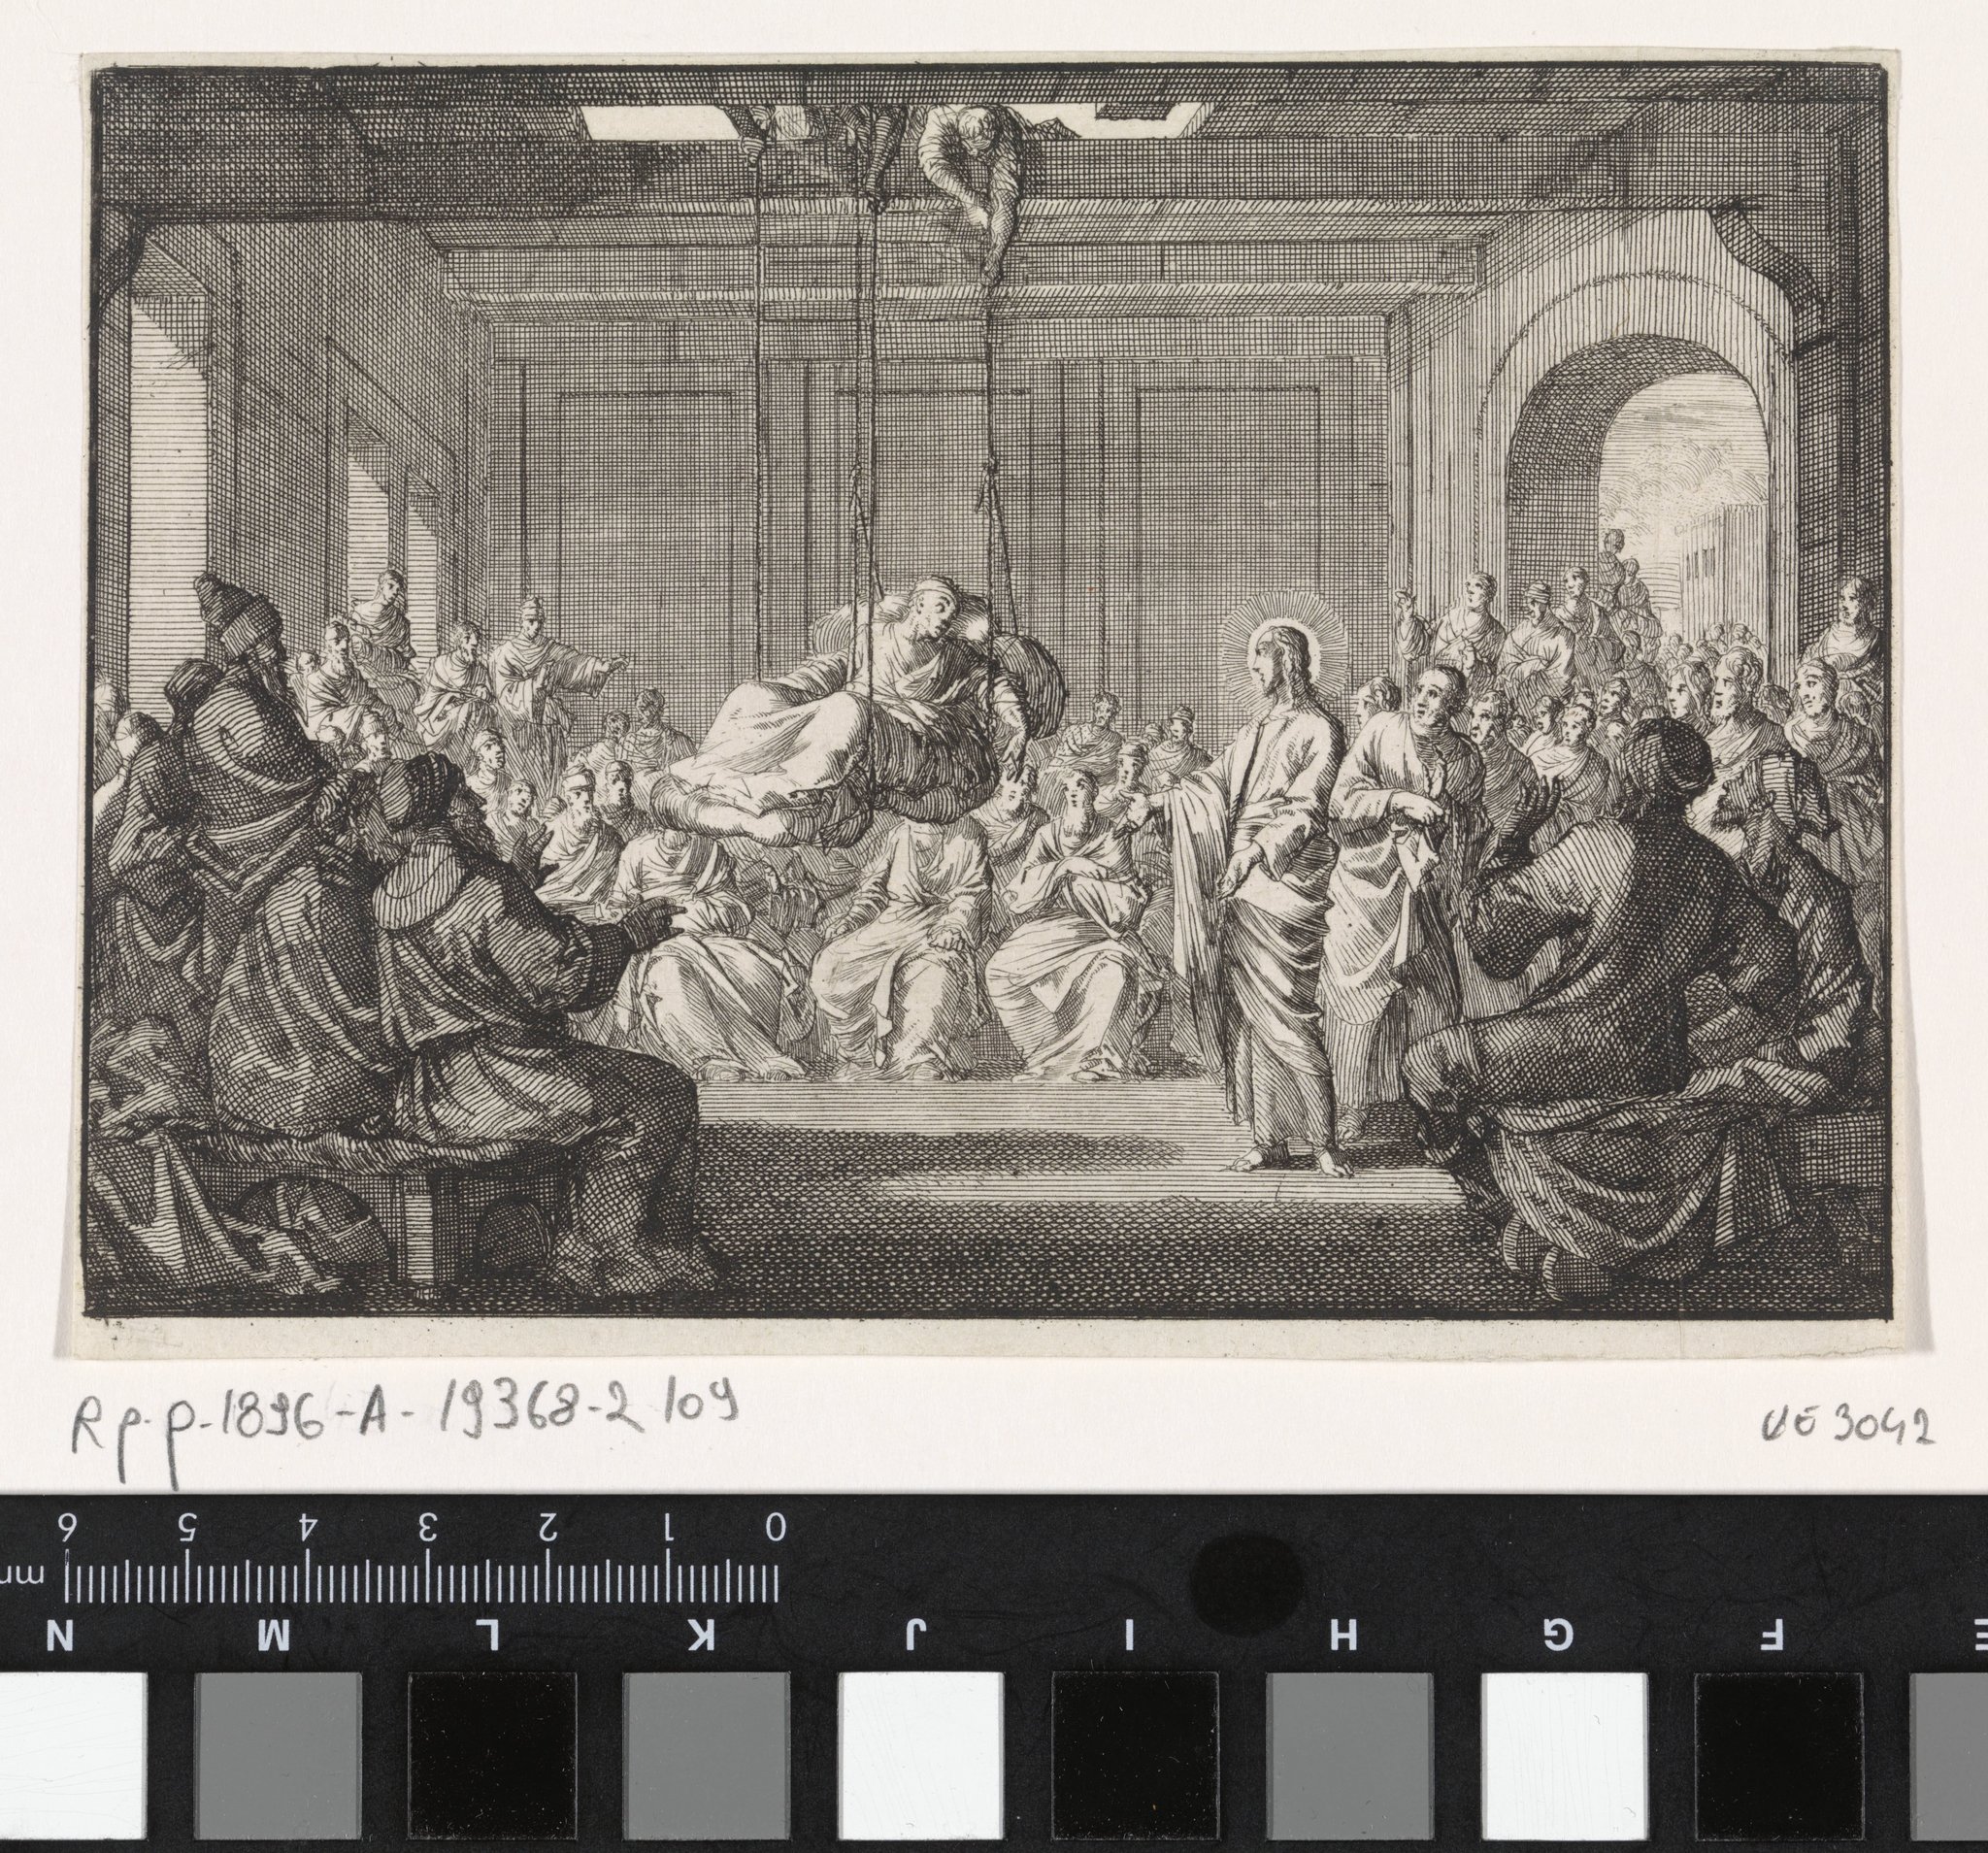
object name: print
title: Genezing van een lamme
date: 1703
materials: paper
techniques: etching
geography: amsterdam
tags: a paralytic is let down through the roof of the house where christ is preaching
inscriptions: collector's mark: Lugt 2228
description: Proefdruk van een boekillustratie voor David Martin. Historie des Ouden en Nieuwen Testaments. Amsterdam, Pieter Mortier, 1703. Deel II. De boekillustraties voor de Mortierbijbel hebben verschillende staten en kopieën, waarbij de chronologische volgorde moeilijk te achterhalen valt. Als boekillustraties werden ze bovendien herhaaldelijk opnieuw gebruikt voor andere boekwerken.